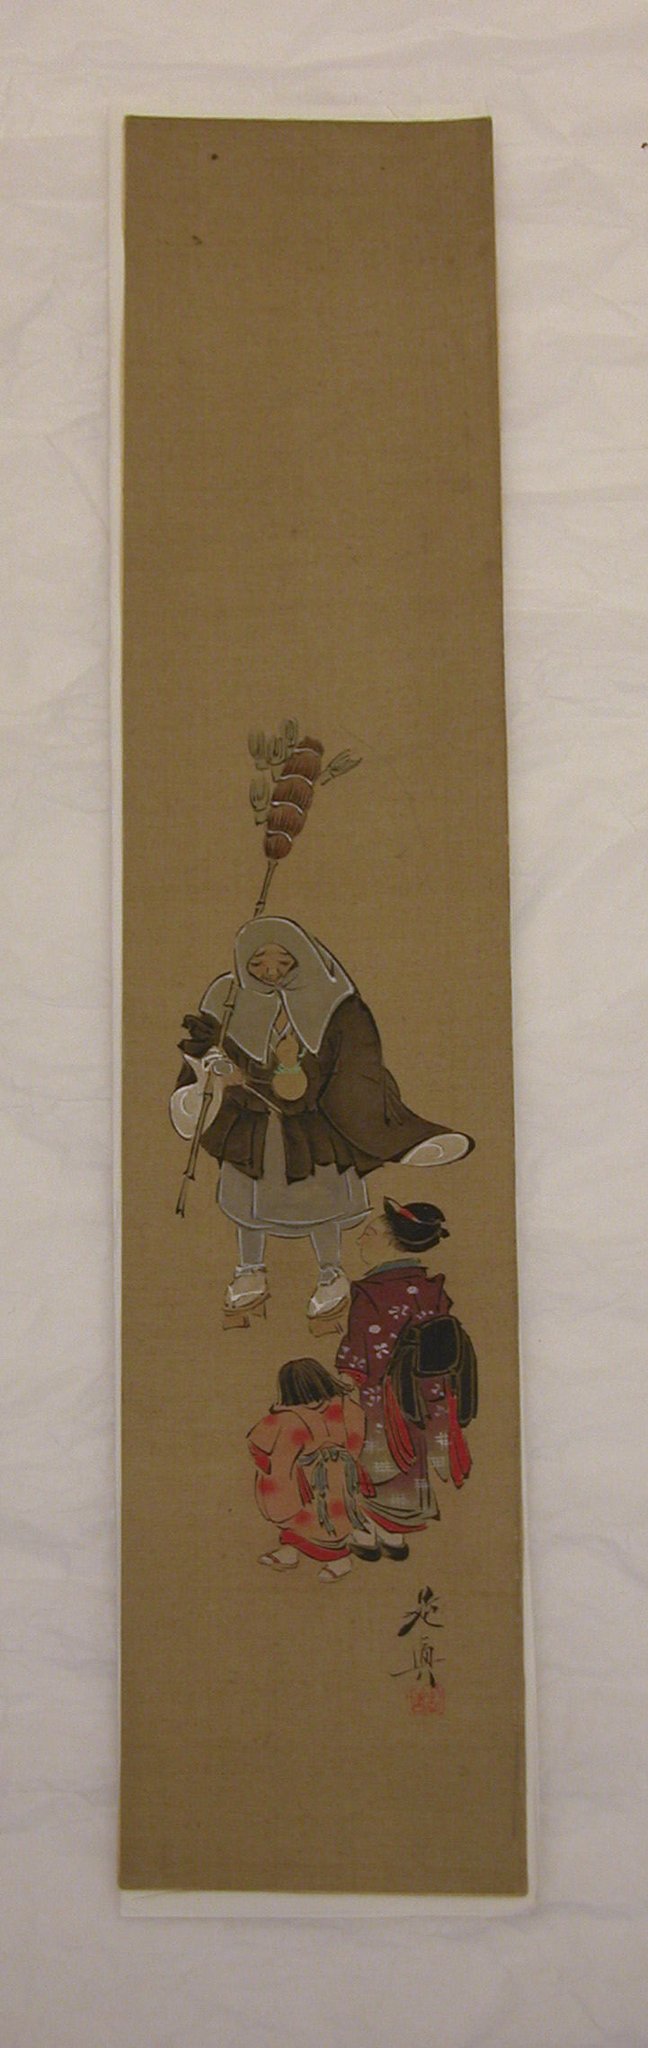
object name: painting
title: Group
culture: japanese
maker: shibata zeshin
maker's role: artist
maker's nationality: japanese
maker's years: 1807-1891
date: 1801-1900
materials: ink, paper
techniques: painting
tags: children,men,women